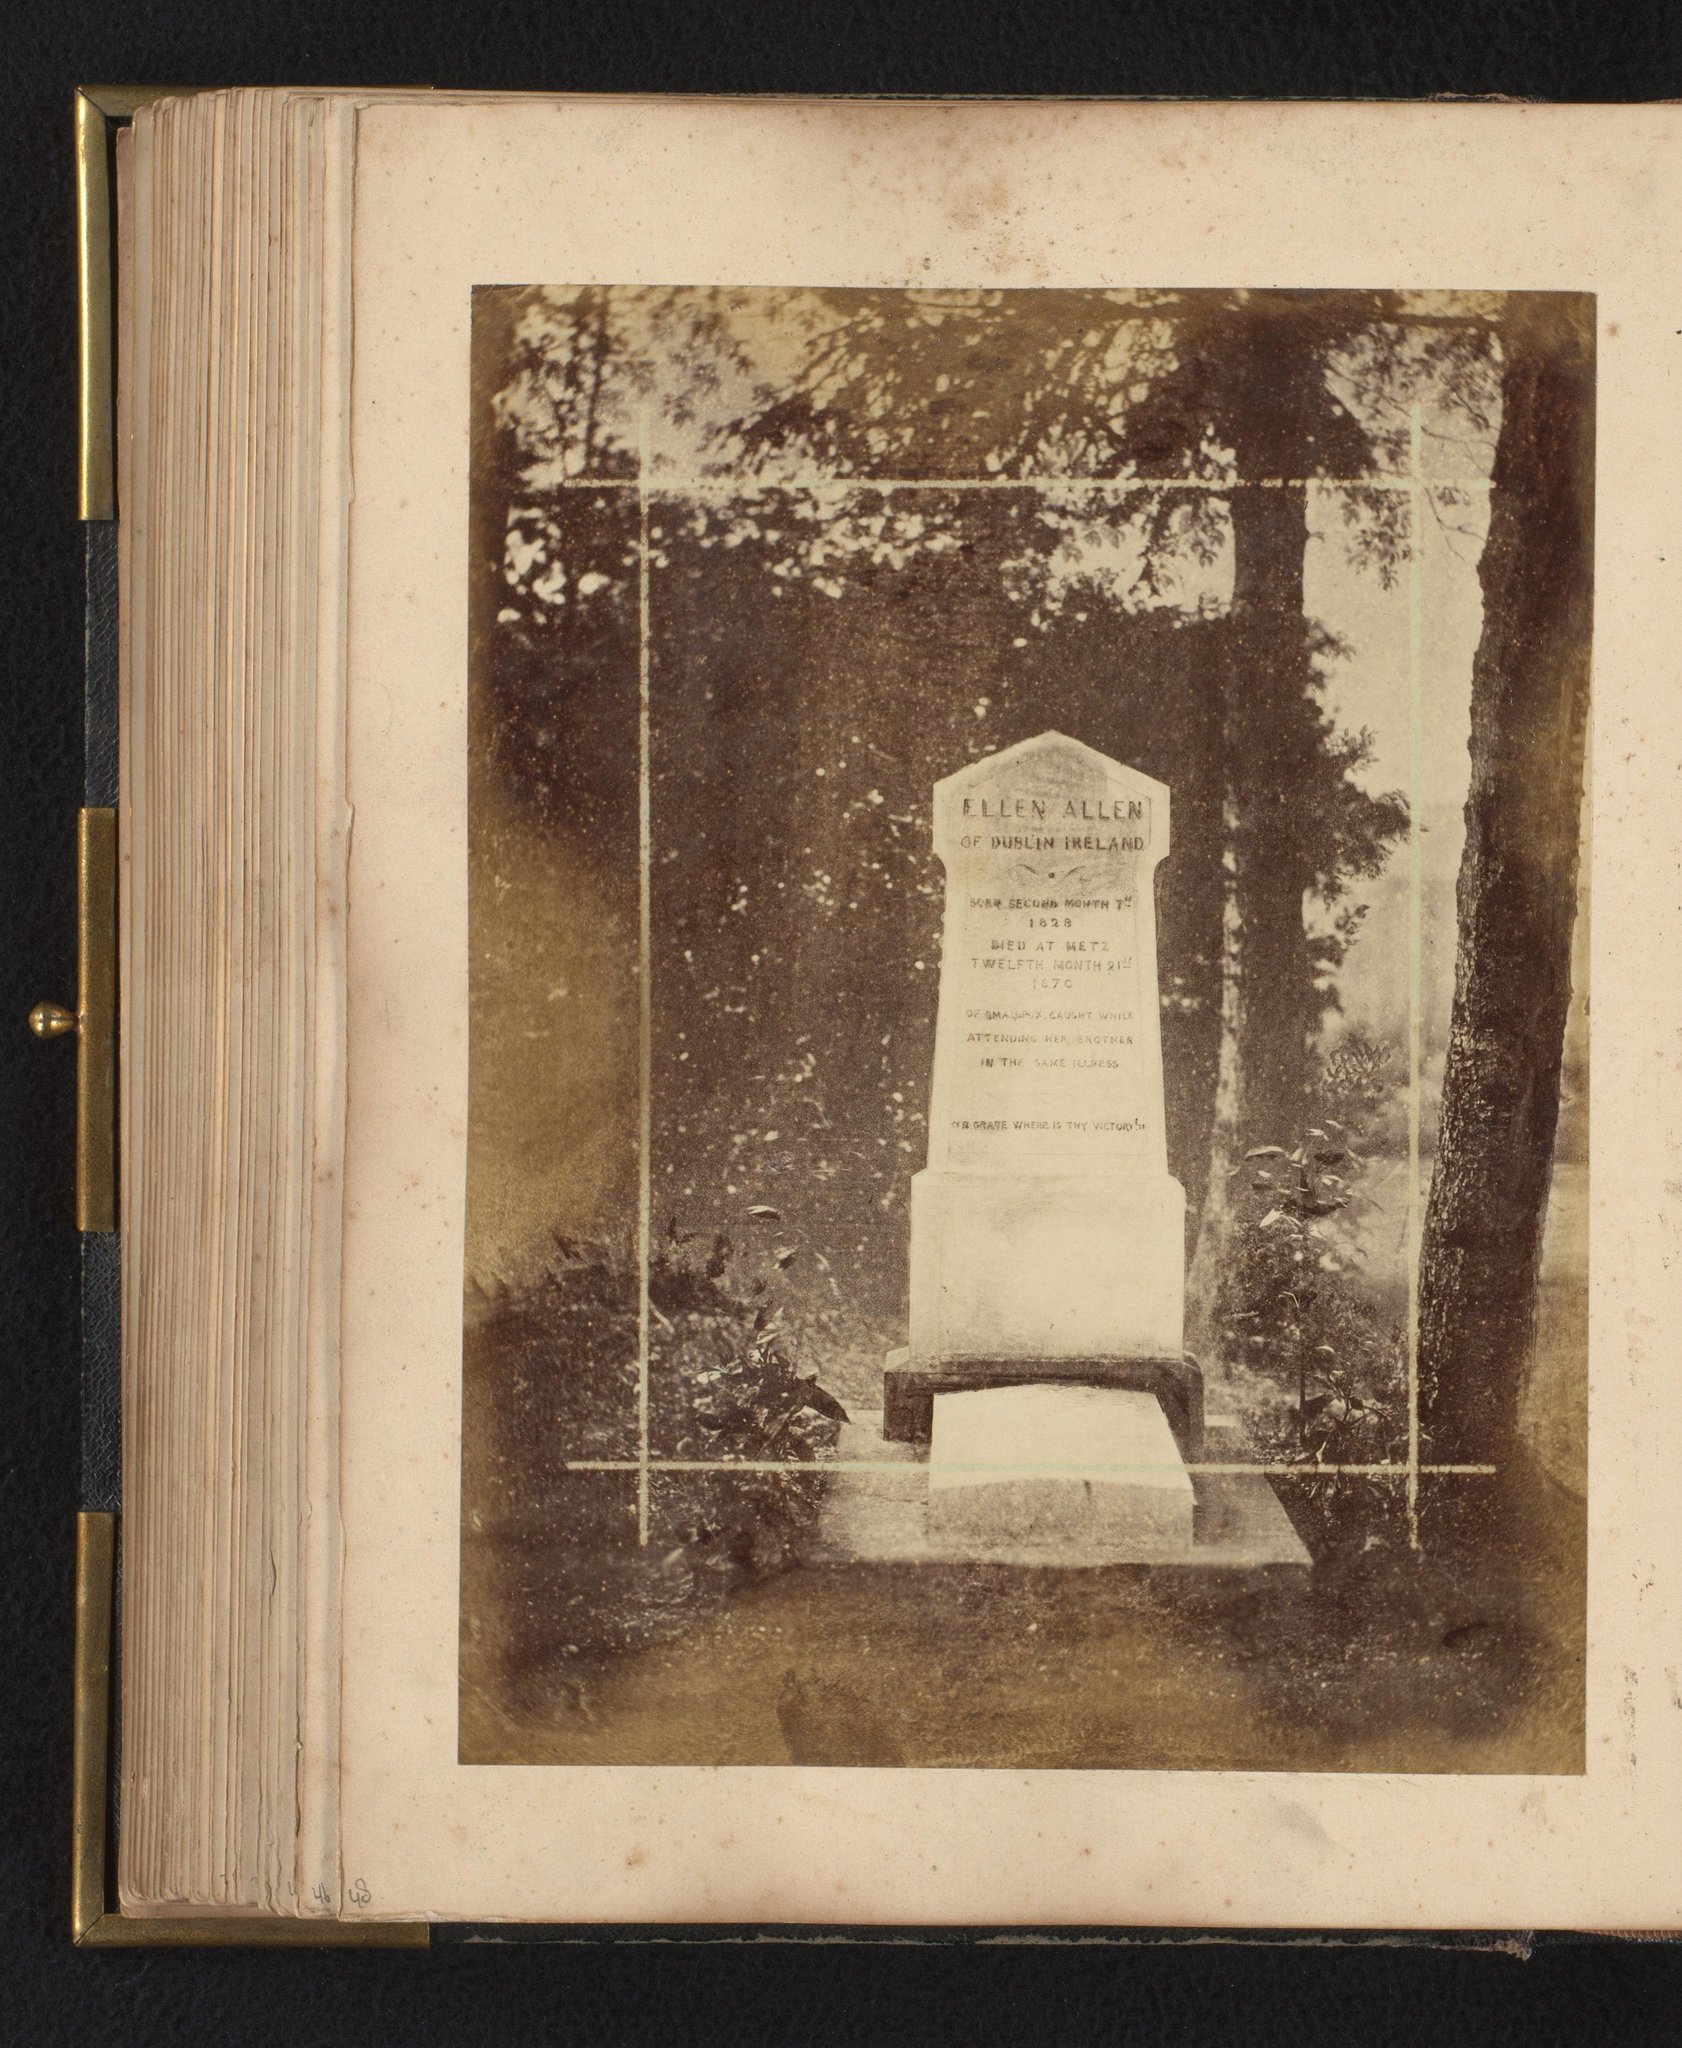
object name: photograph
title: Graf van Ellen Allen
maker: Anonymous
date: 1866-1871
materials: photographic support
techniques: albumen print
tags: gravestone, tombstone